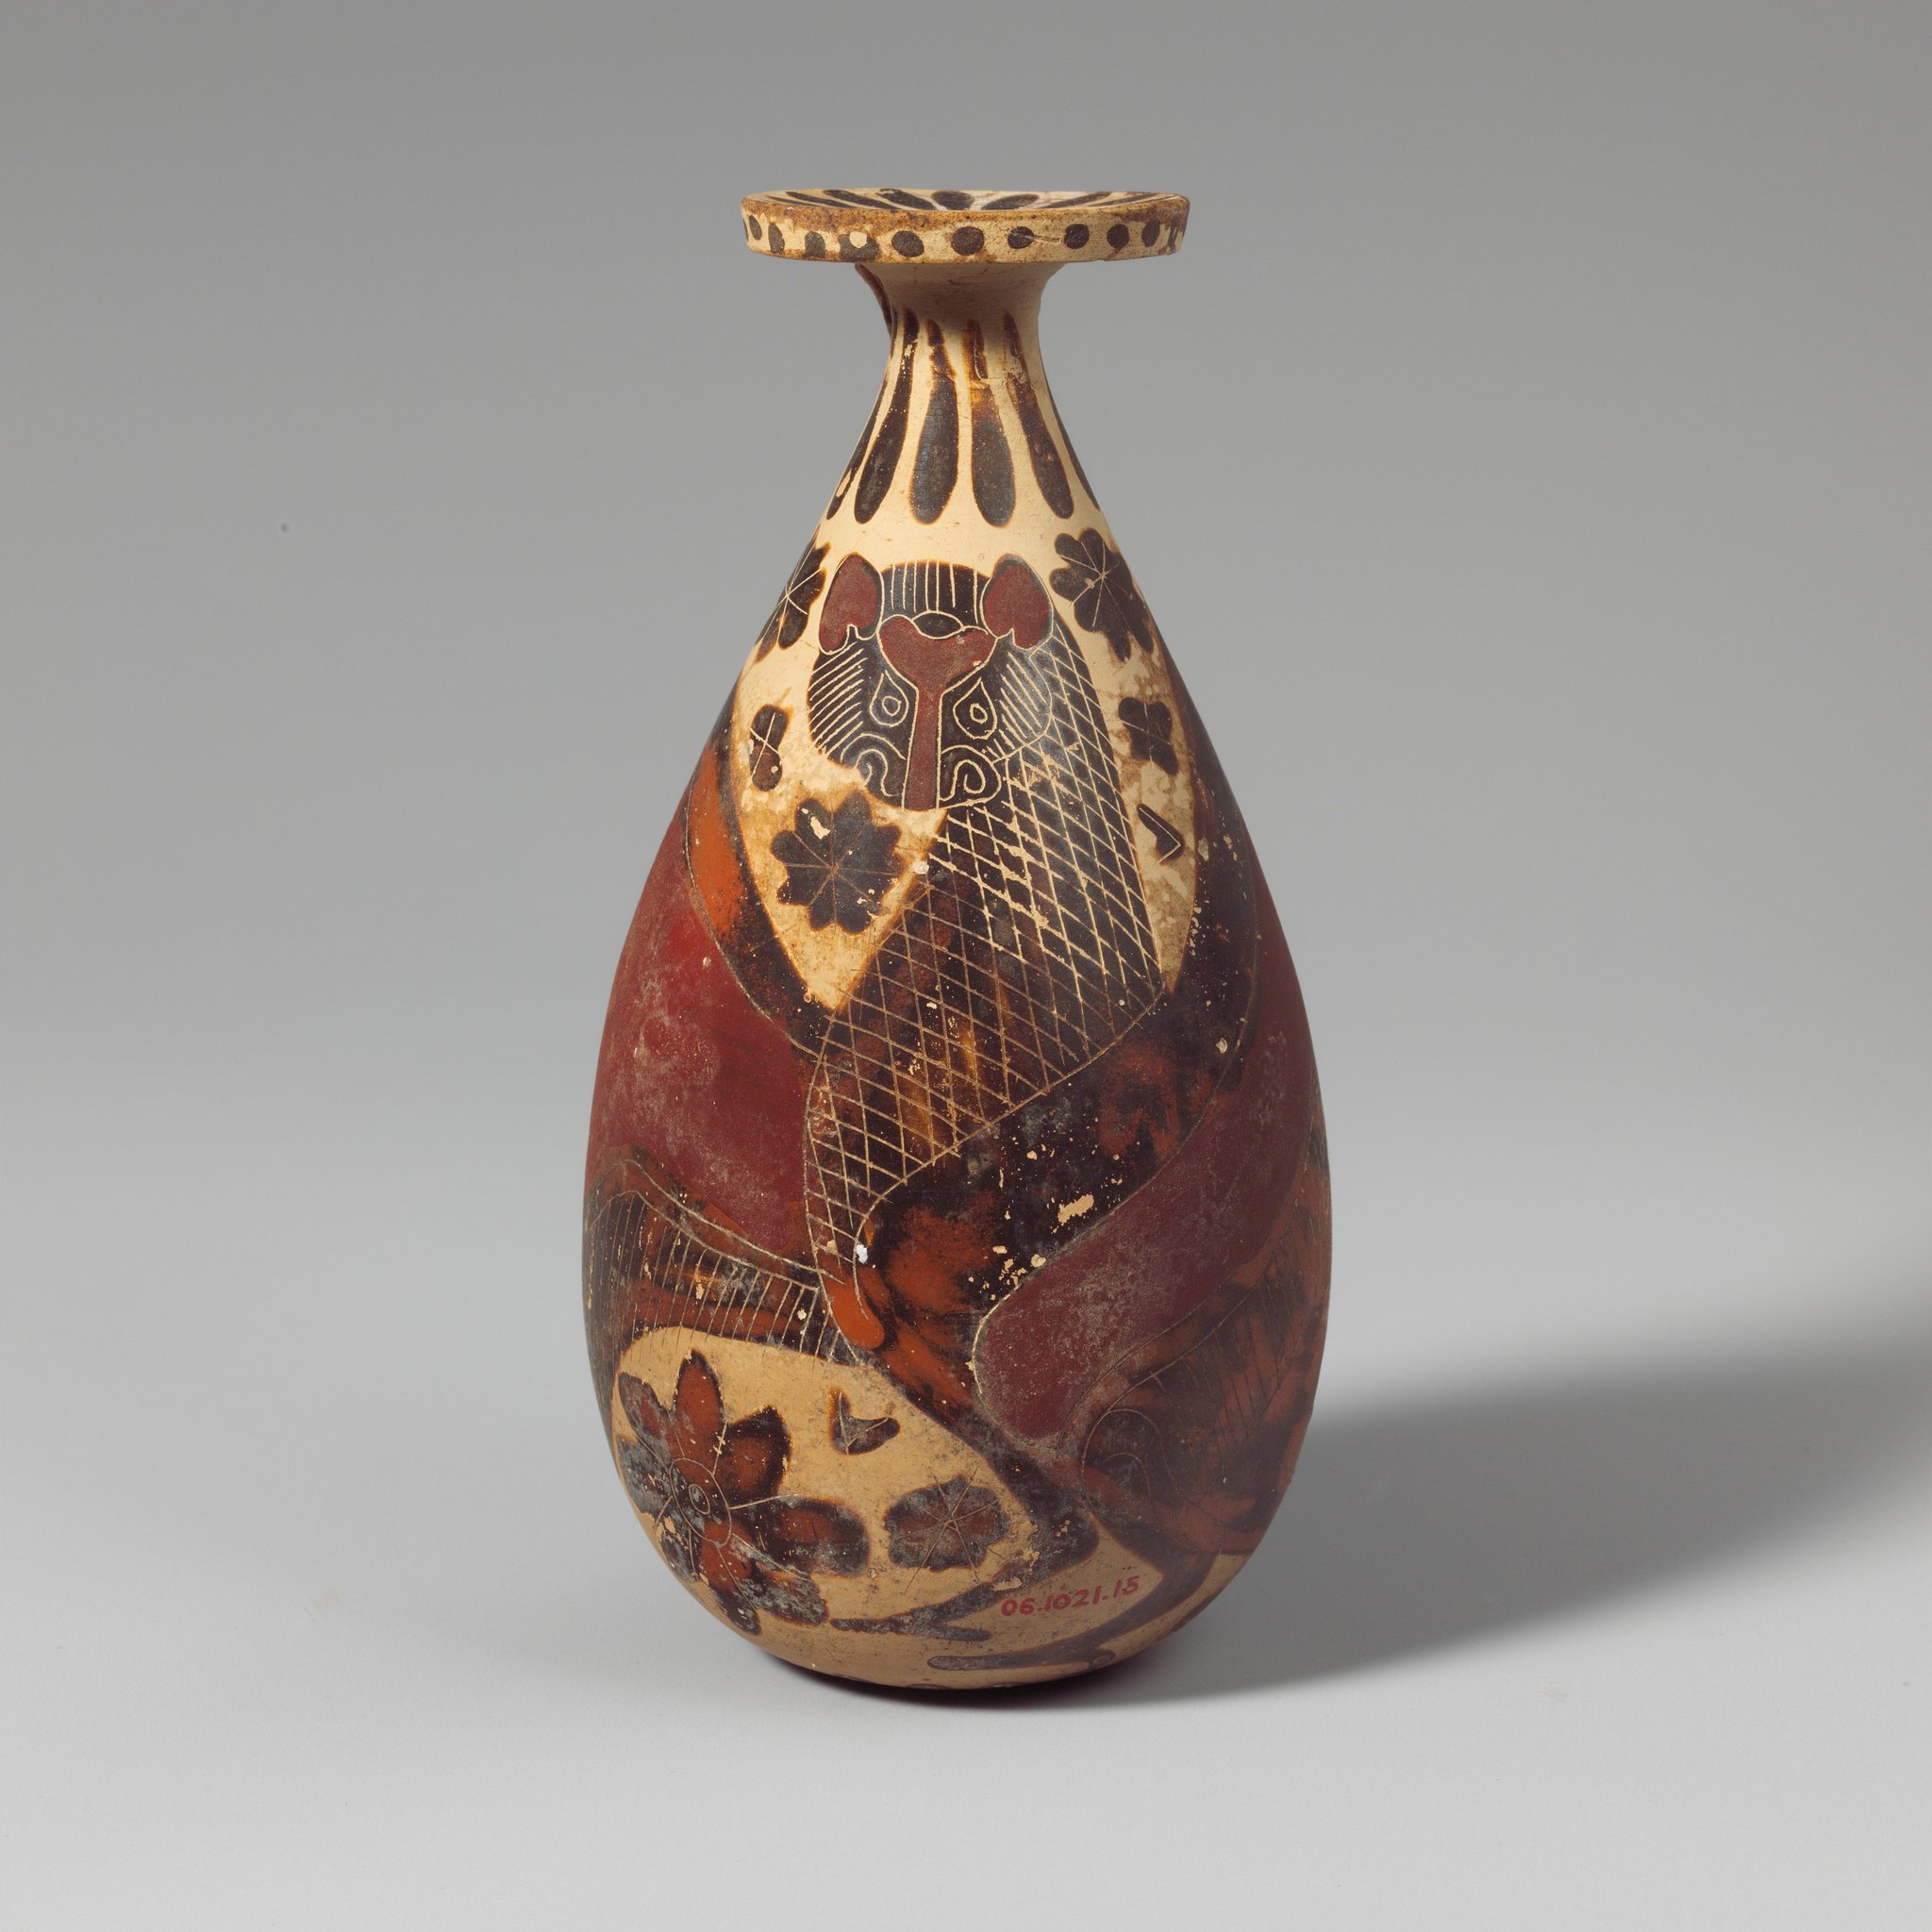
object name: alabastron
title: Terracotta alabastron (perfume vase)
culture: greek, corinthian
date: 620-590 BCE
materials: terracotta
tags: birds,panthers